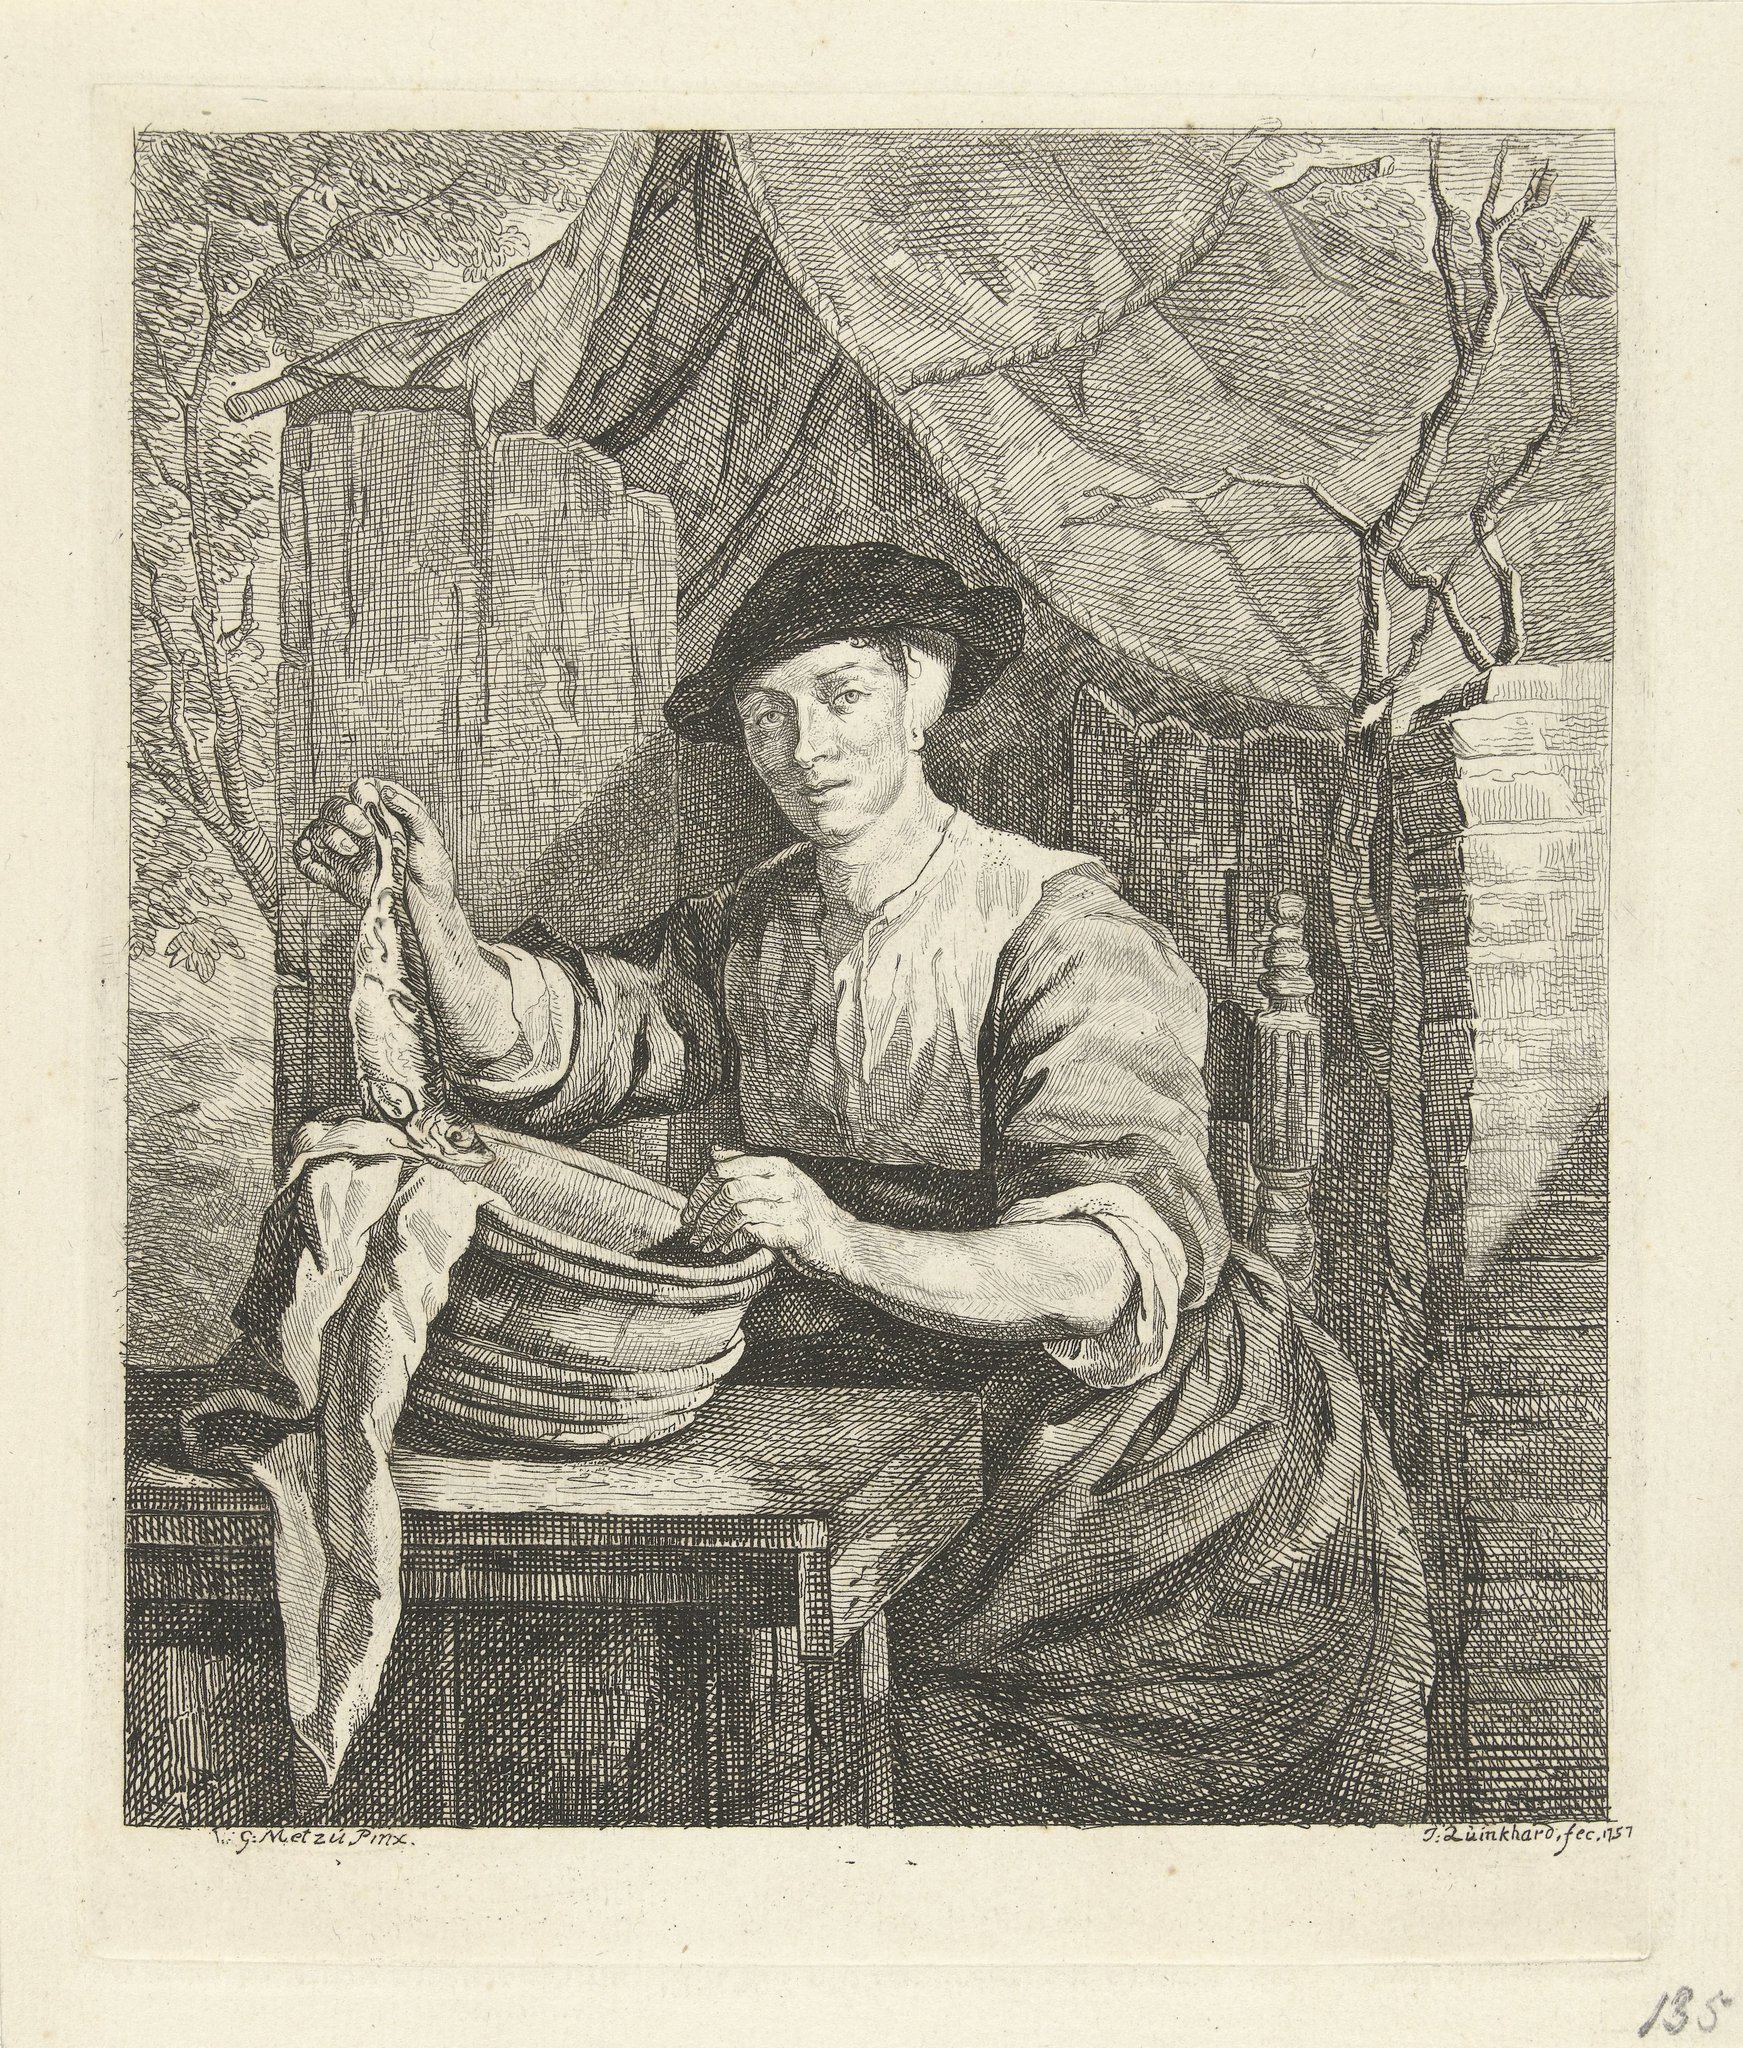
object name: print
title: Visvrouw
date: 1757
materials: paper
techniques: etching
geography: amsterdam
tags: fishes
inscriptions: collector's mark: Lugt 240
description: Voor een hut zit een visvrouw aan een tafel. Zij haalt een vis uit een bak.